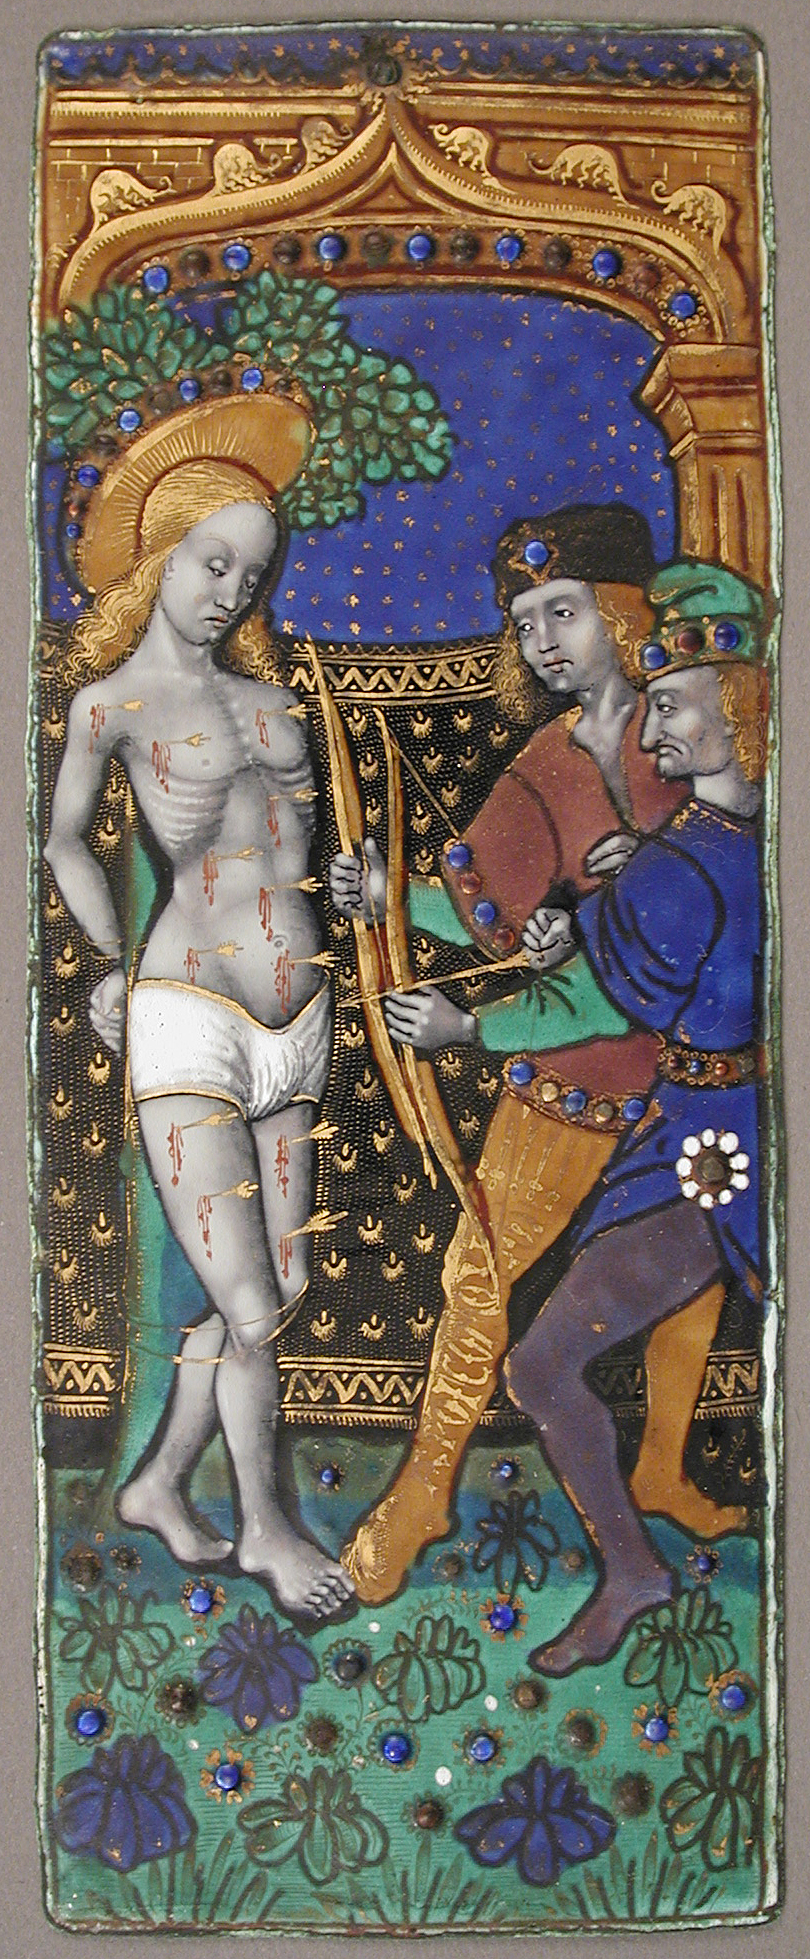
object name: triptych panel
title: Triptych Panel with Saint Sebastian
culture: french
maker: master of the triptych of louis xii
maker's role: artist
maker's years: 1480-1525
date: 1401-1600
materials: copper, enamel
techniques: painting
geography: france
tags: bow and arrow,men